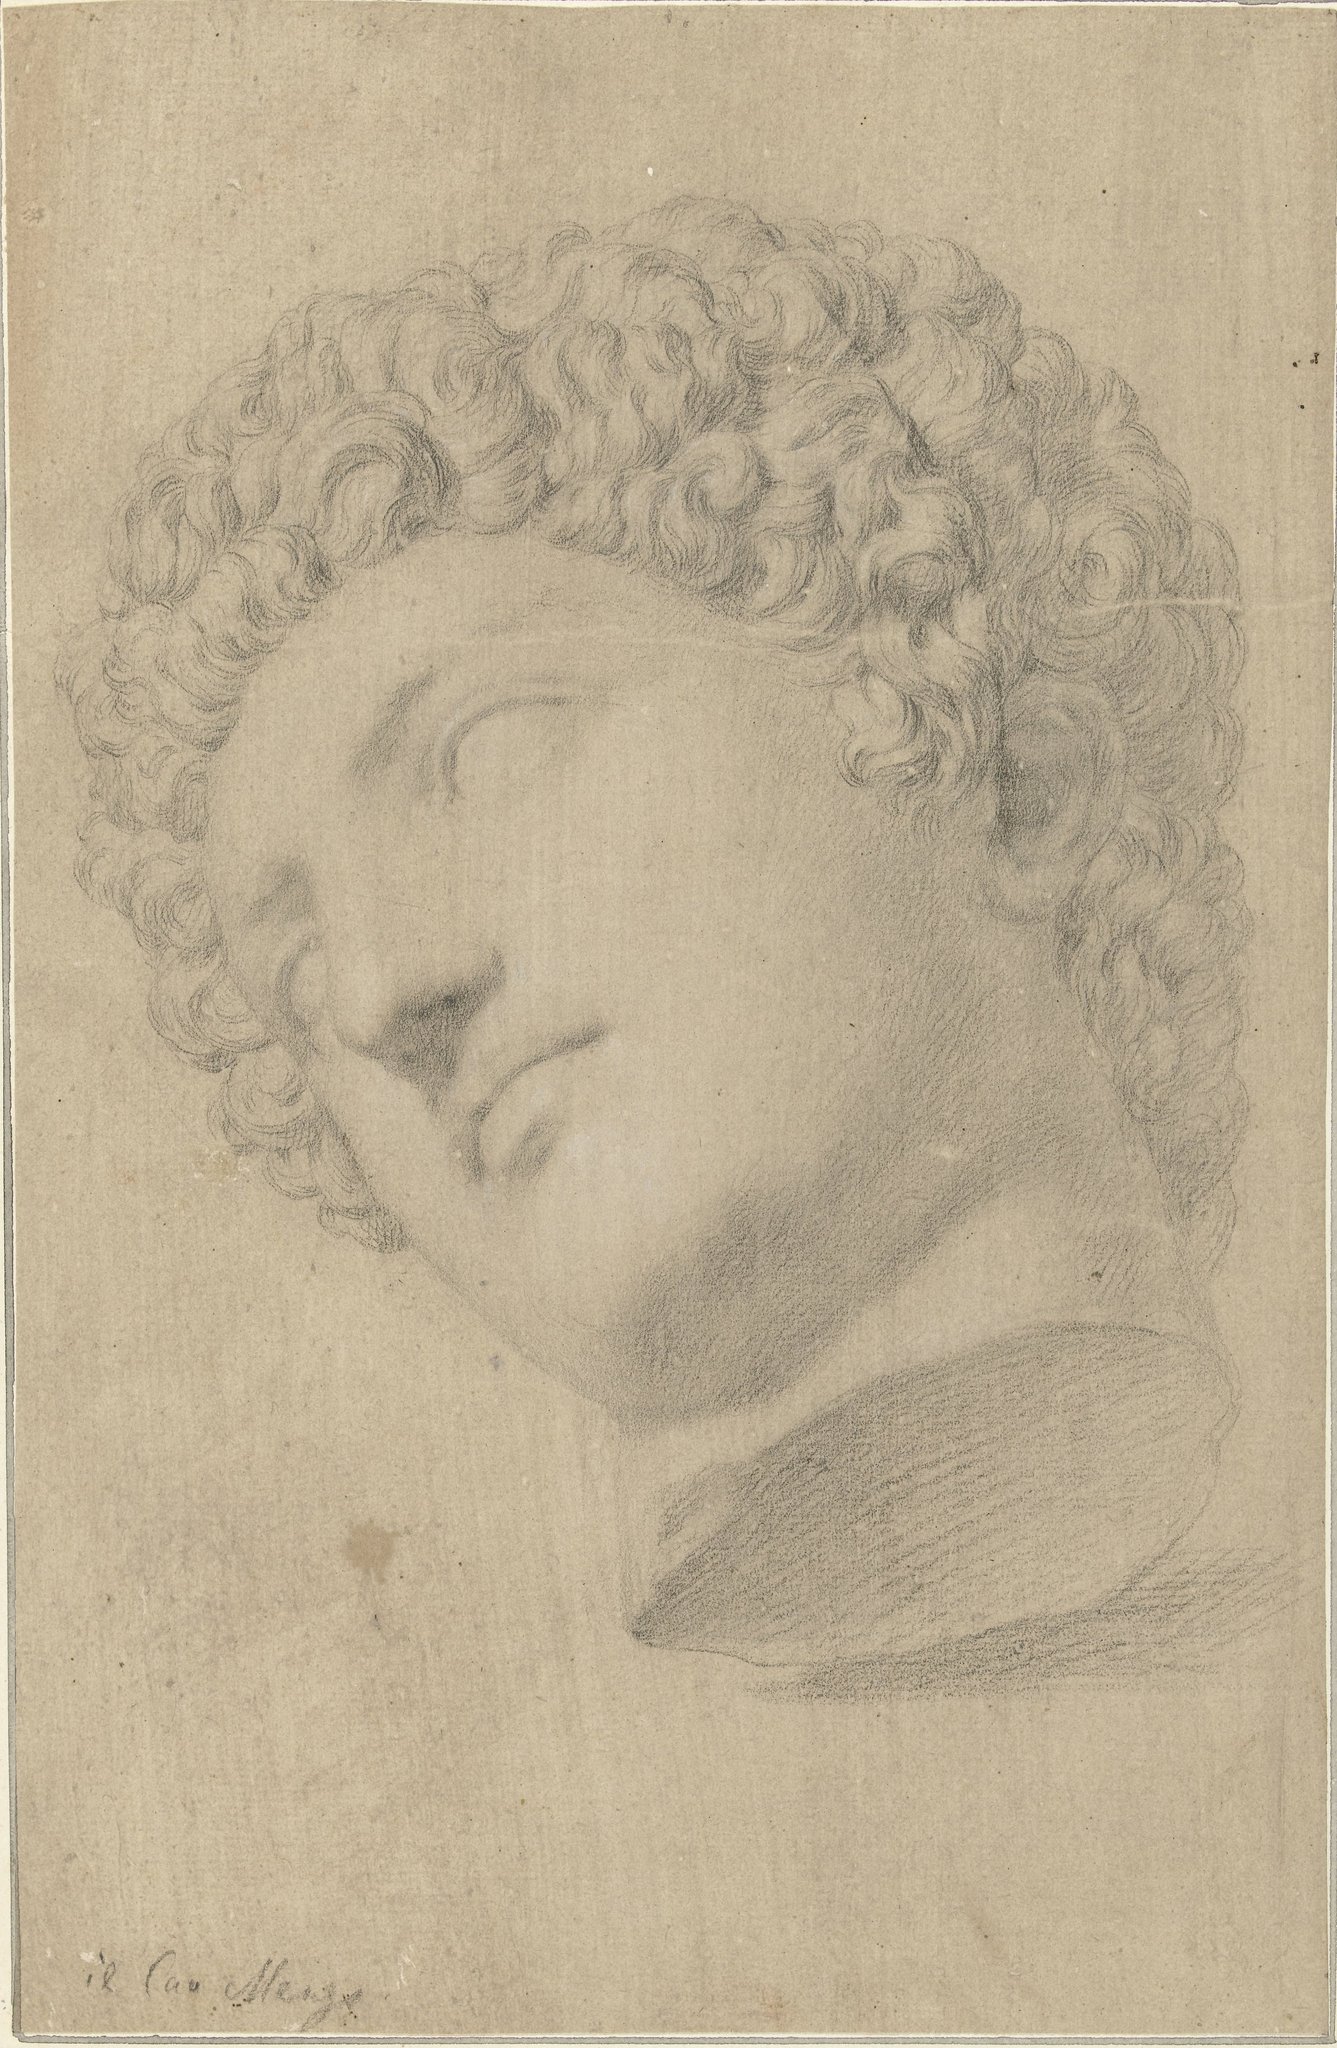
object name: drawing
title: Jongelingshoofd, van onderen gezien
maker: anton raphael mengs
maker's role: draughtsman, painter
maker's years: 1728-1779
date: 1738-1779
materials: chalk, paper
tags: piece of sculpture, reproduction of a piece of sculpture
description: Jongelingshoofd, van onderen gezien, naar antiek voorbeeld in pleister.